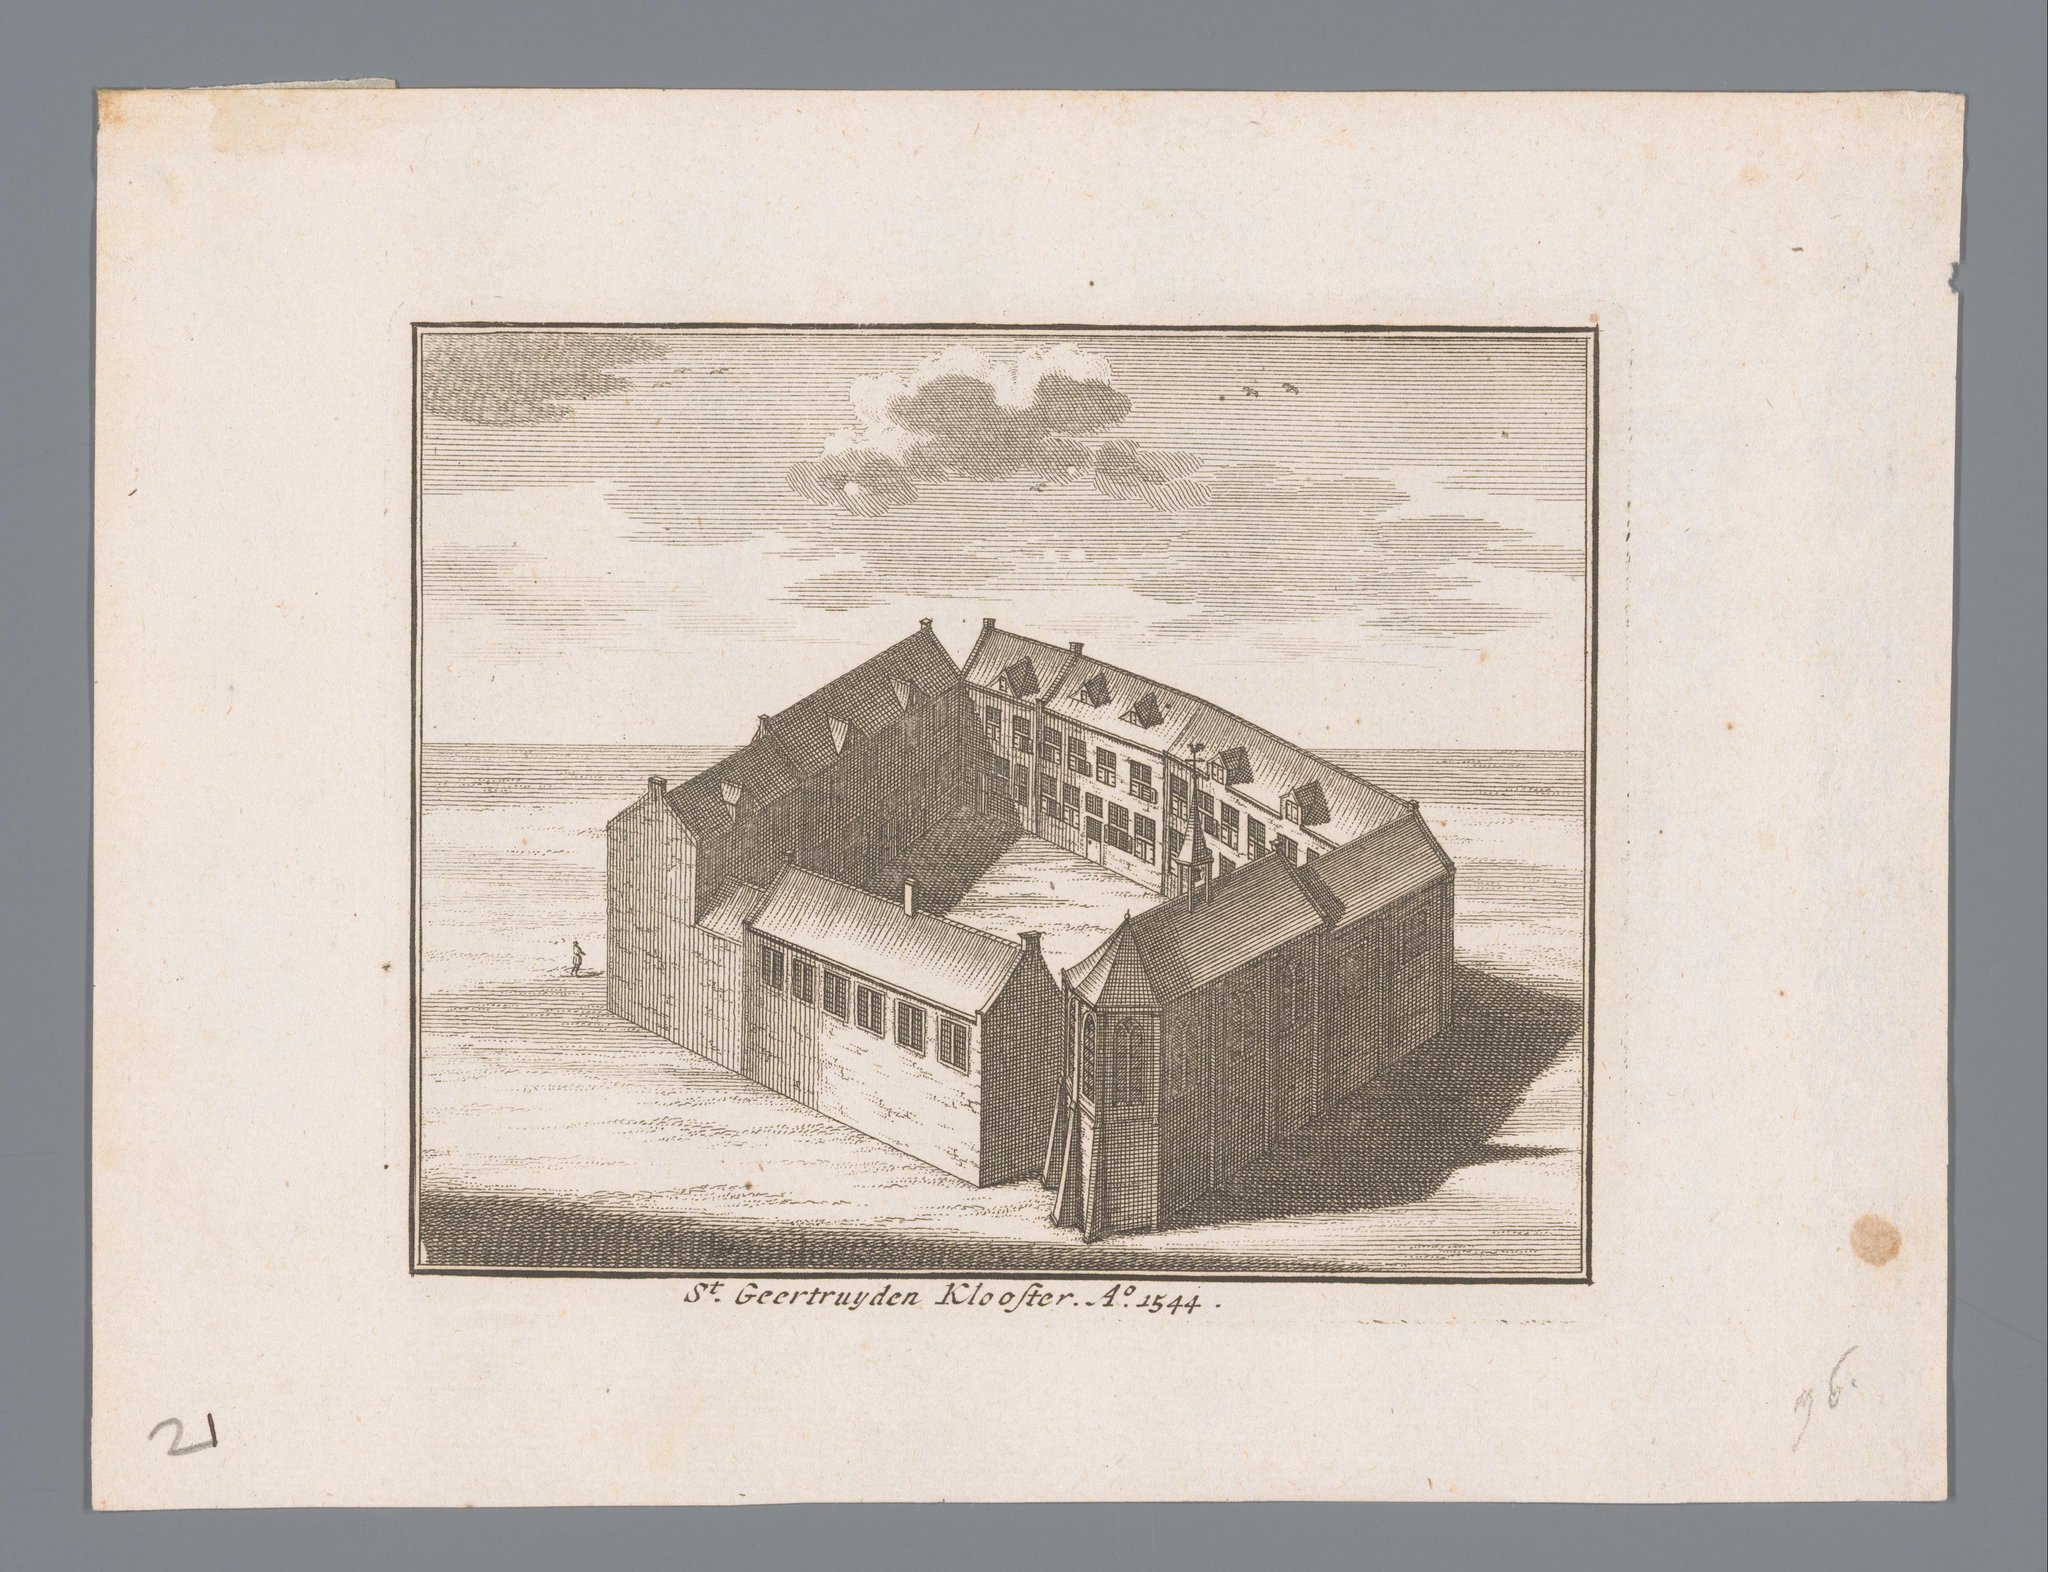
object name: print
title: Gezicht in vogelvlucht op het Sint-Geertruidenklooster te Amsterdam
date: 1729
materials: paper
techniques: etching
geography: amsterdam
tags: abbey, monastery, convent ~ roman catholic church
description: Prent verschenen in: Long, Isaak Le. Historische beschryvinge van de Reformatie der stadt Amsterdam. Amsterdam: Johannes van Septeren, 1729.